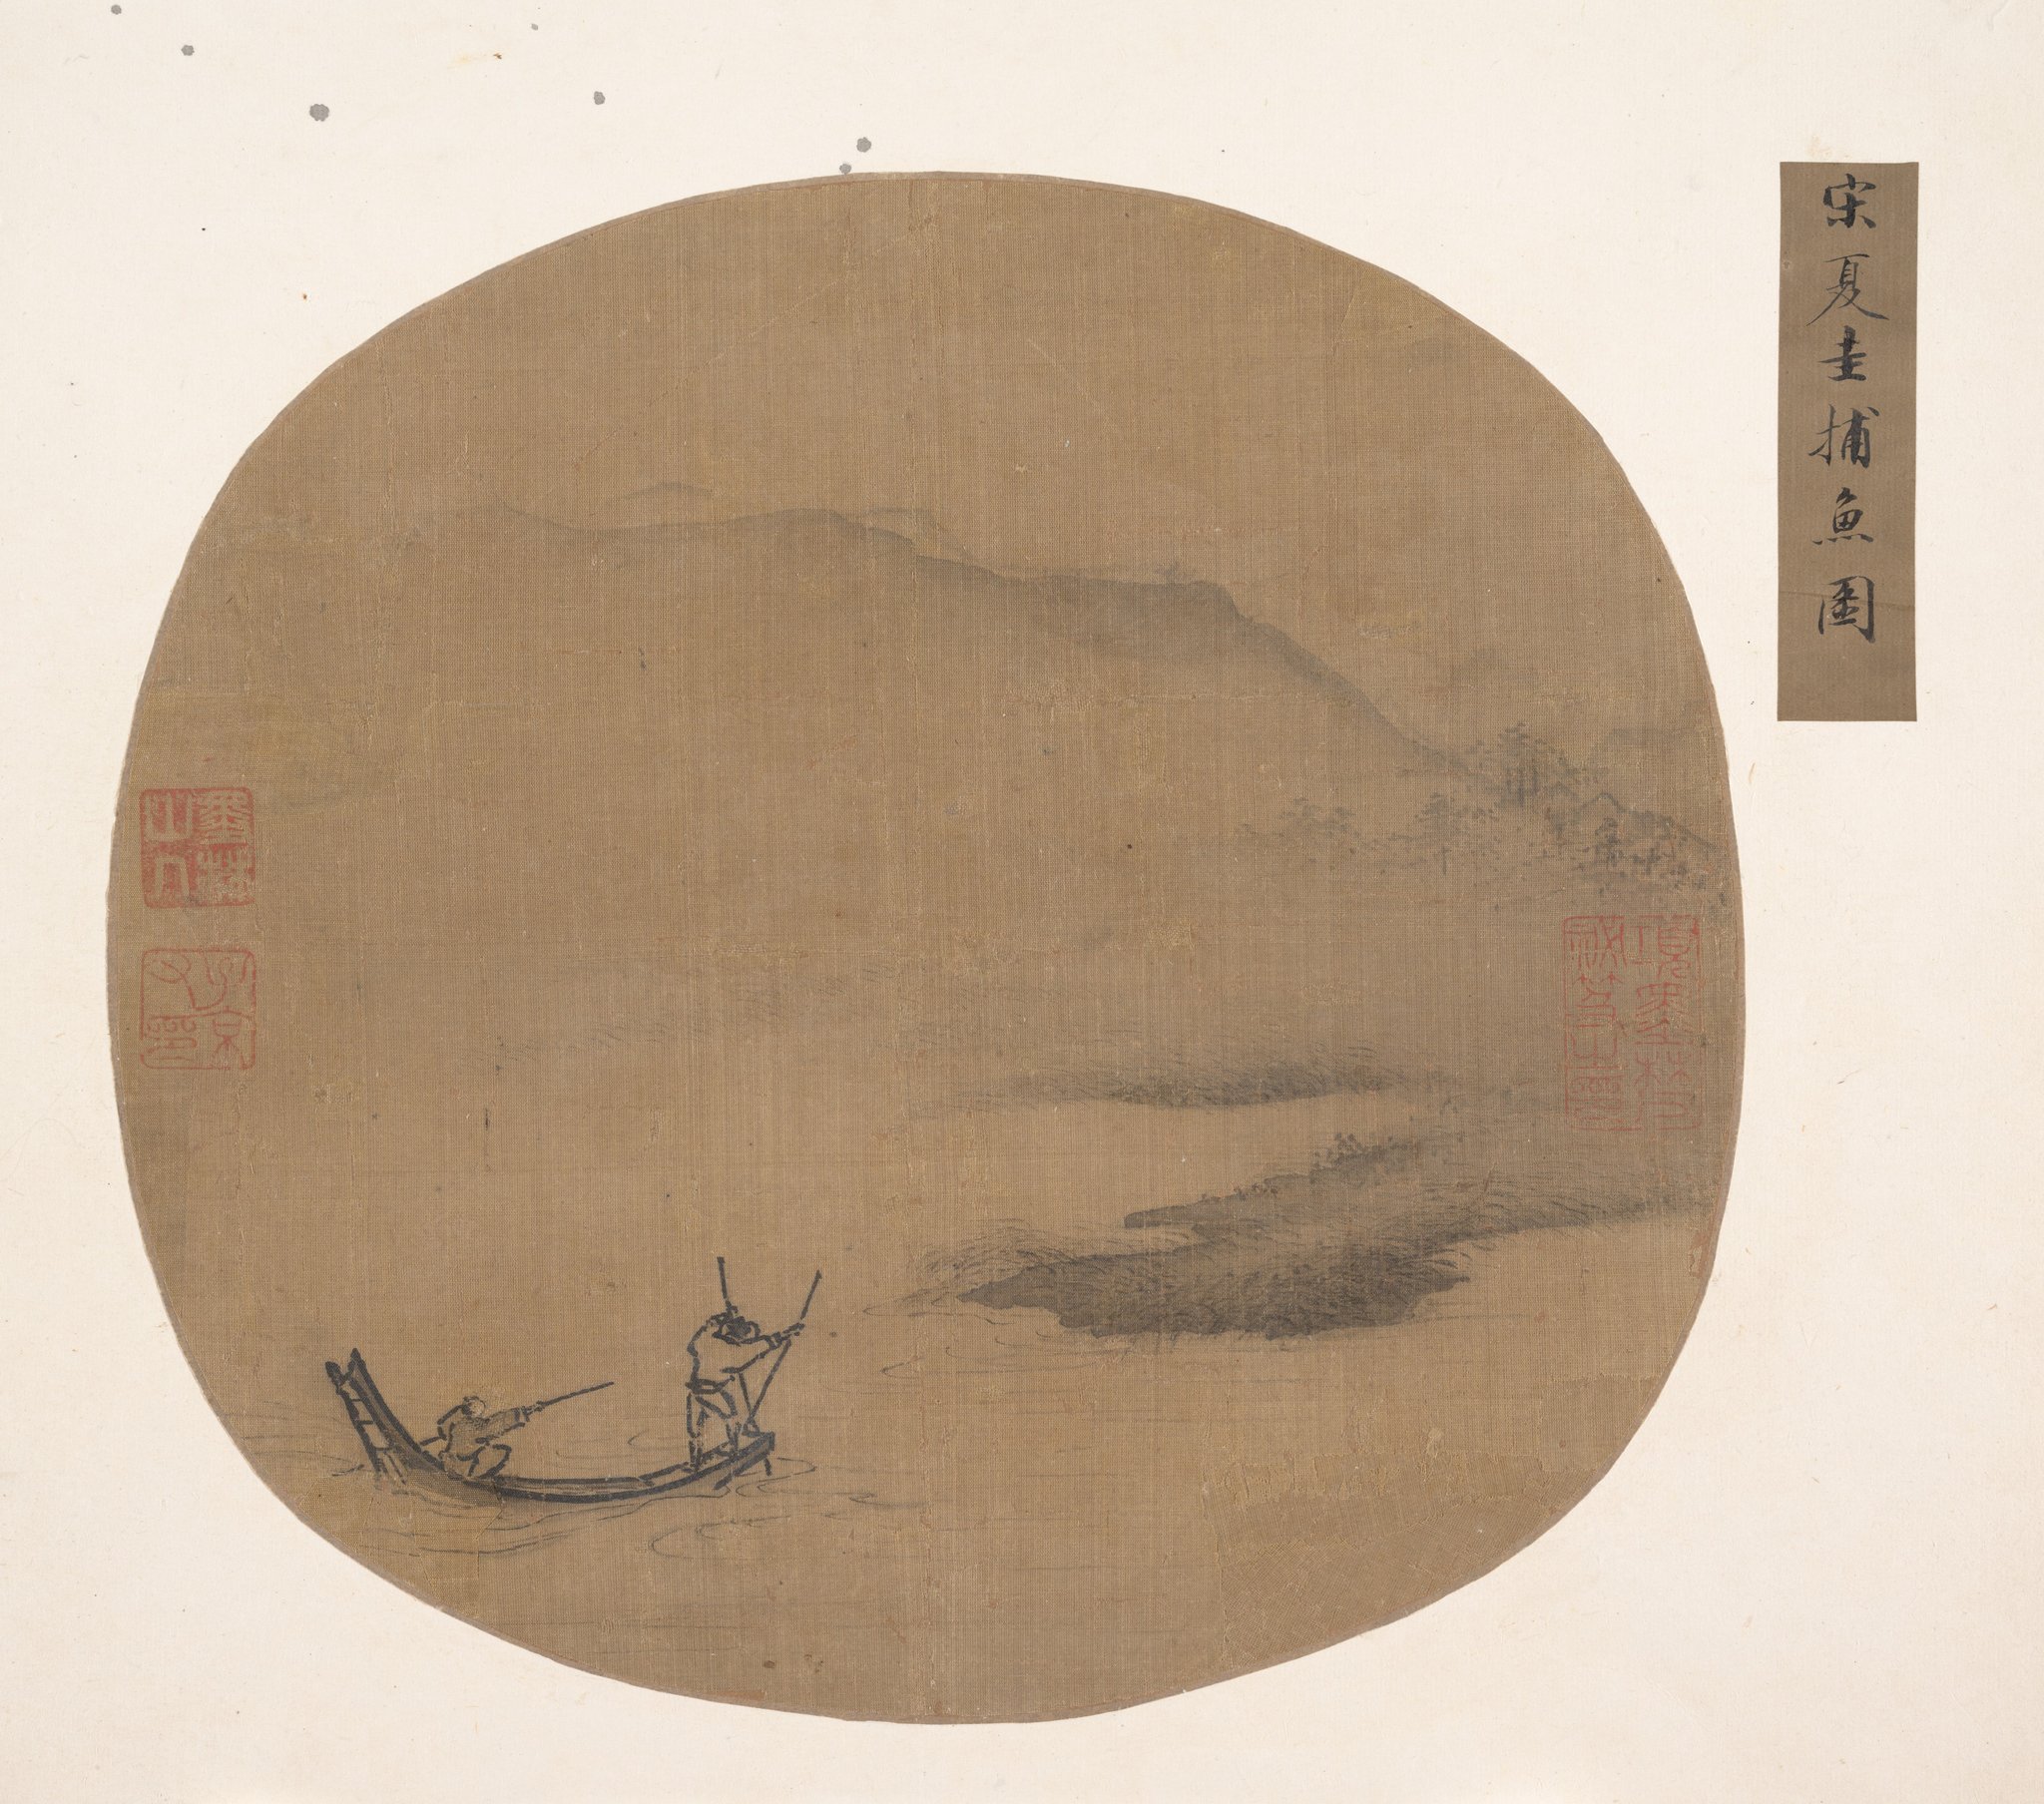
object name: fan mounted a an album leaf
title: River Landscape with Boatmen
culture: chinese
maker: unidentified artist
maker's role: artist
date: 1368-1644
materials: ink, silk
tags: men,landscapes,boats